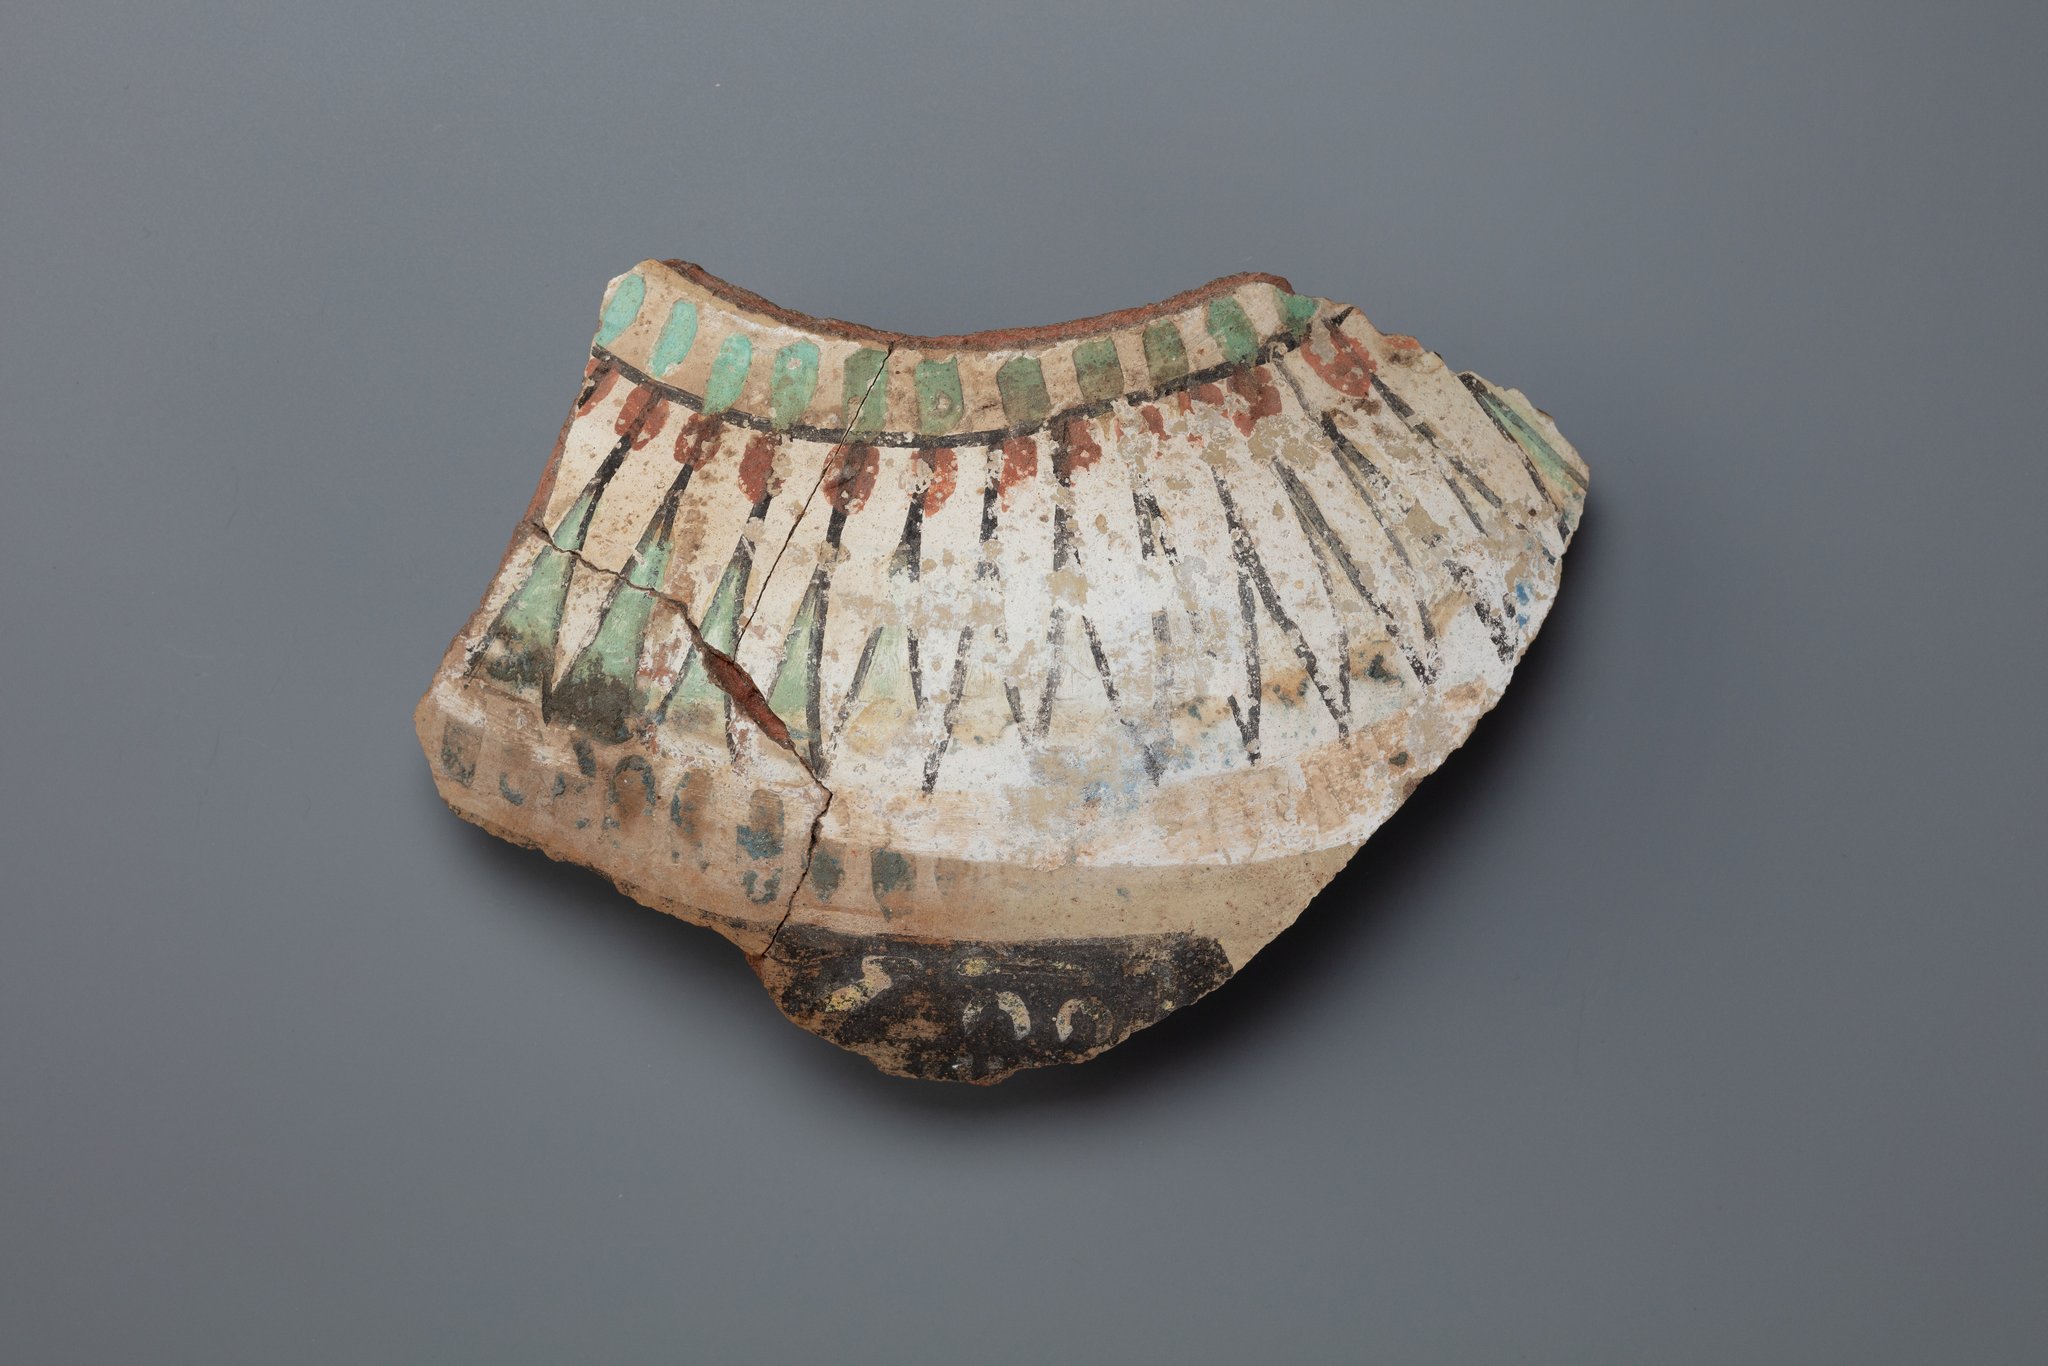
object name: jar fragment, inscribed, malqata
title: Decorated jar fragment with inscription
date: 1390-1352 BCE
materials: ink, paint, pottery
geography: egypt